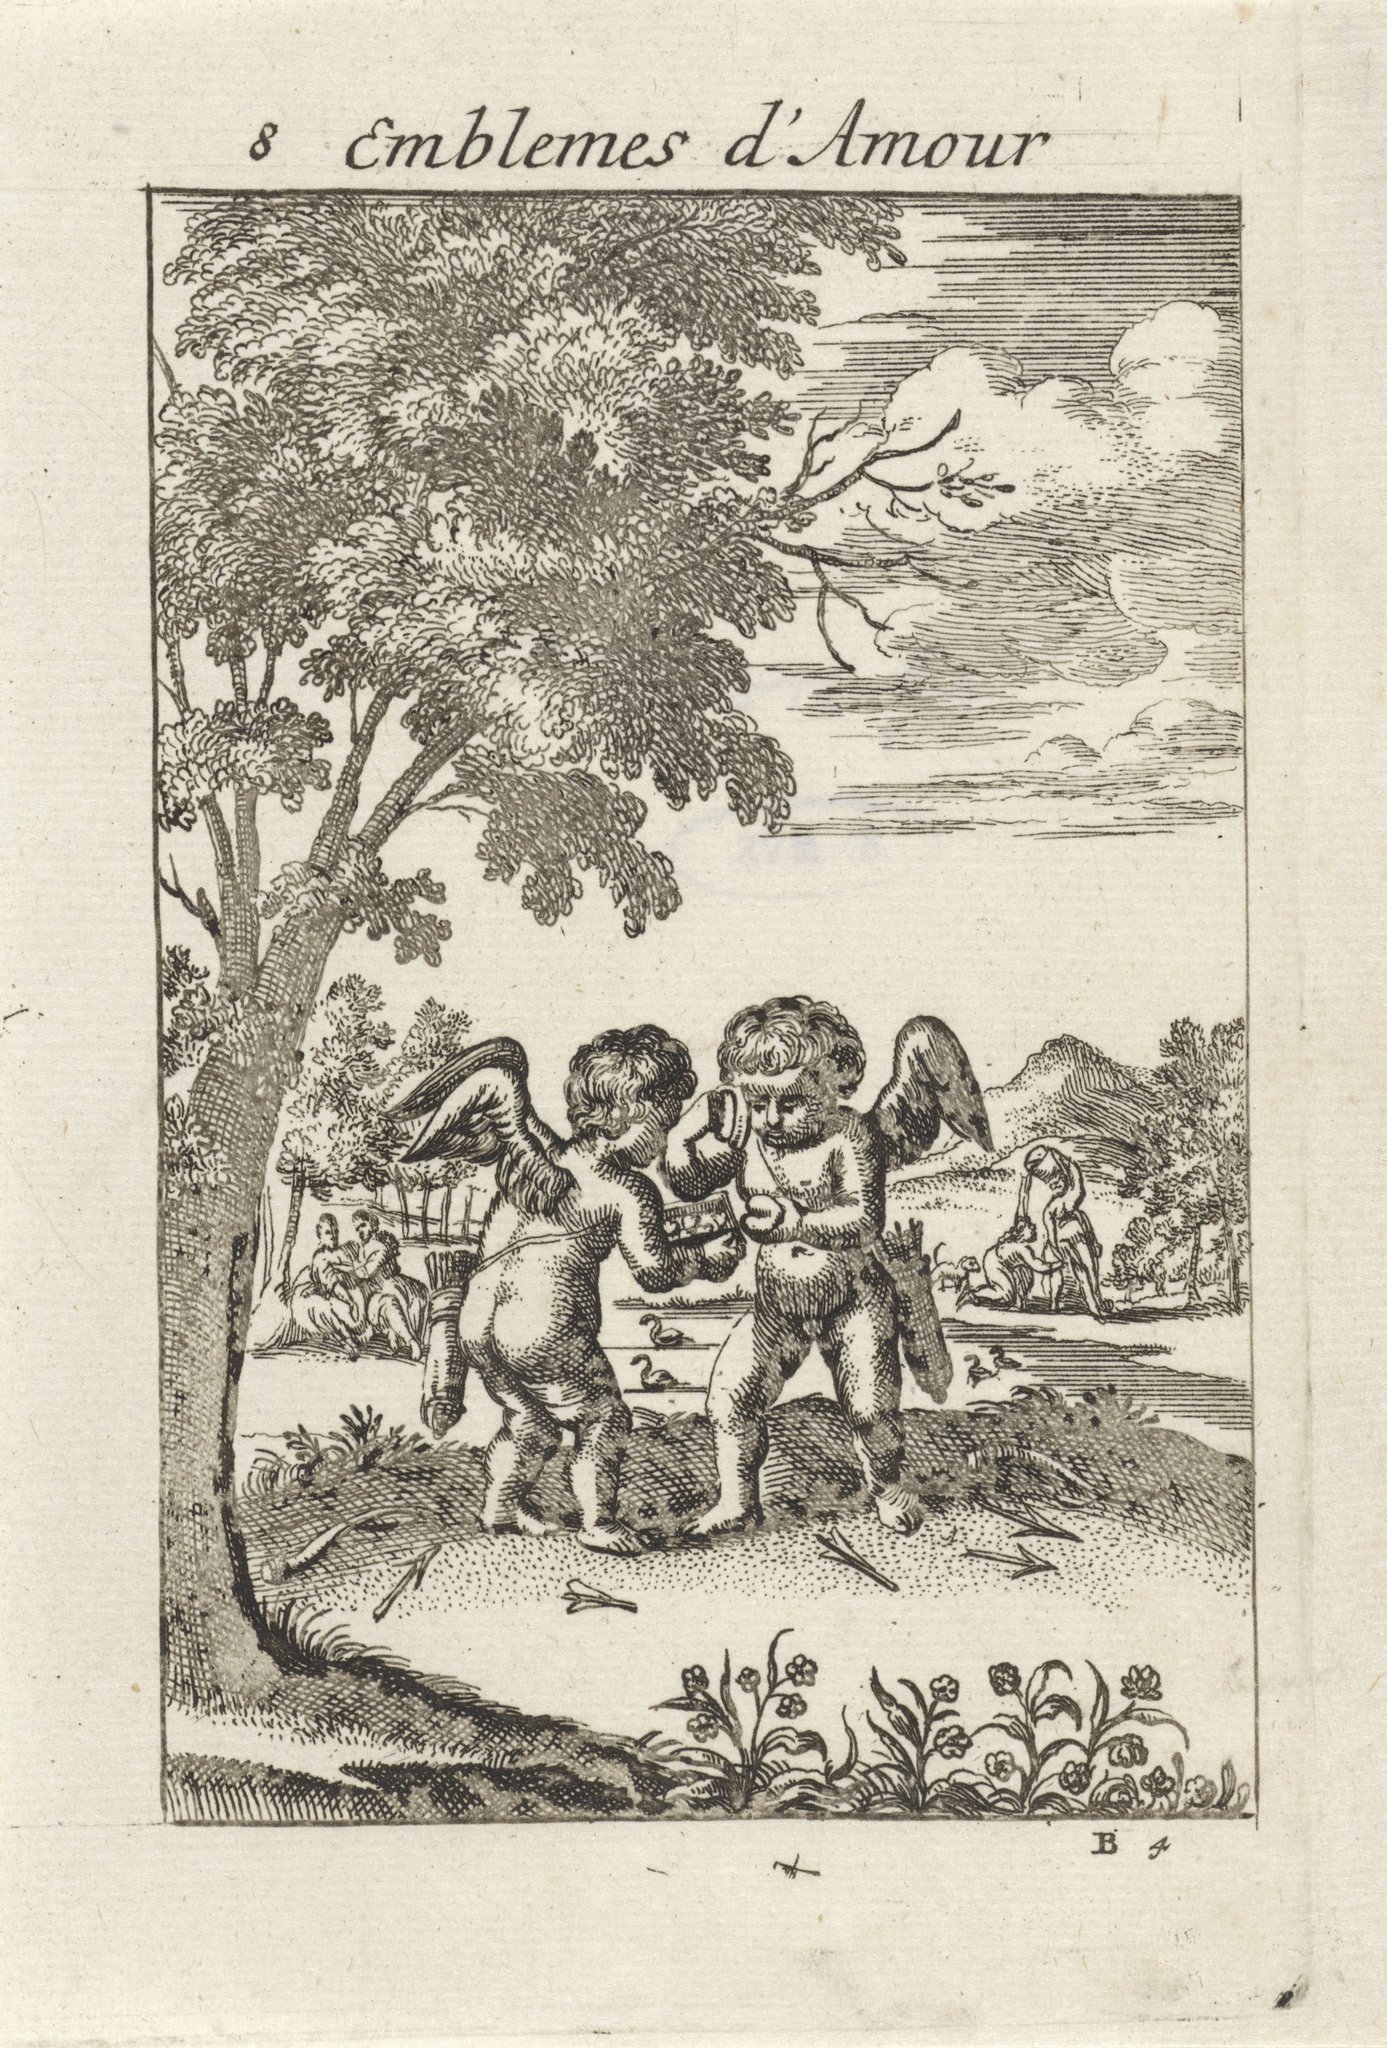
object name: print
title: Emblemes d'Amour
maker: jan van vianen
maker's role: print maker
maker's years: 1660-1726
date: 1686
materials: paper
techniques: etching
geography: northern netherlands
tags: tinder-box, spark ~ fire (+ variant), (story of) cupid, amor (eros)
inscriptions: collector's mark: Lugt 2228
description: Twee putti proberen tevergeefs een vonk te slaan uit een hart, door er met een vuurslag op te slaan om zo een vuur te maken met een tondeldoos. Op de grond liggen gebroken pijlen. Eenzijdige liefde kan als vonk geen vlam vatten en zal niet beklijven. Achtste embleem uit Emblemata Amatoria.